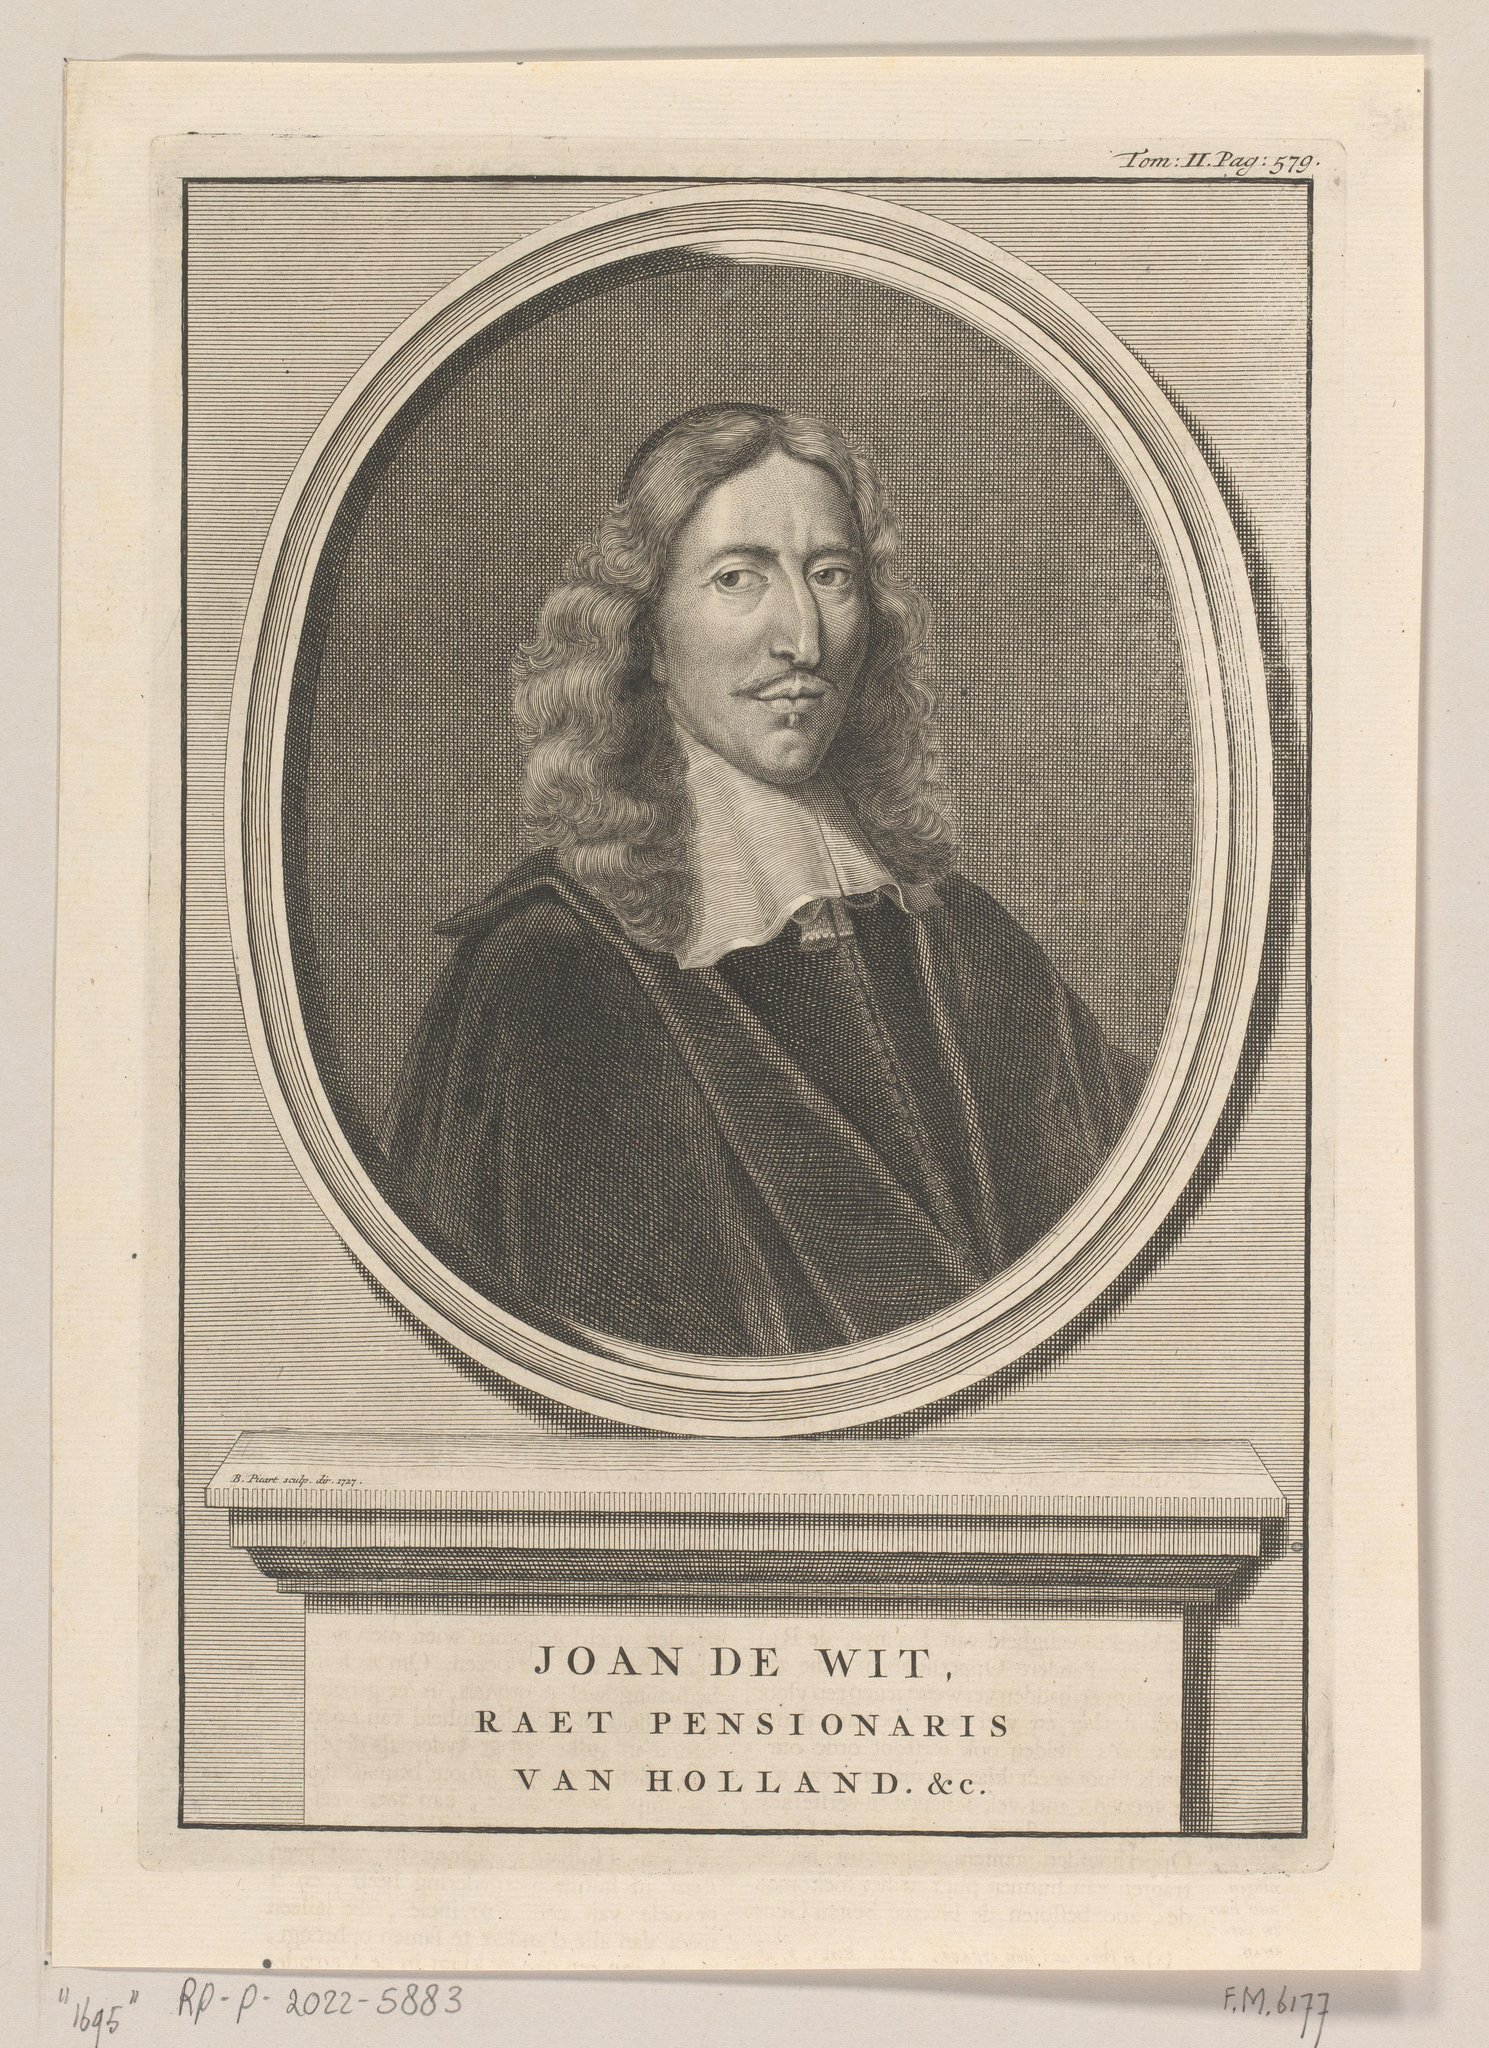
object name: print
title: Portret van Johan de Witt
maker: bernard picart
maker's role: draughtsman, print maker, publisher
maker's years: 1673-1733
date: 1727-1730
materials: paper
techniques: engraving, etching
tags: the hague, politician, johan de witt, historical persons, governor, etc. of province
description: Prent waarschijnlijk uit: Le Clerc, Jean. Geschiedenissen der Vereenigde Nederlanden (...). Amsterdam: Zacharias Chatelain, 1730, dl. 2, p. 579.